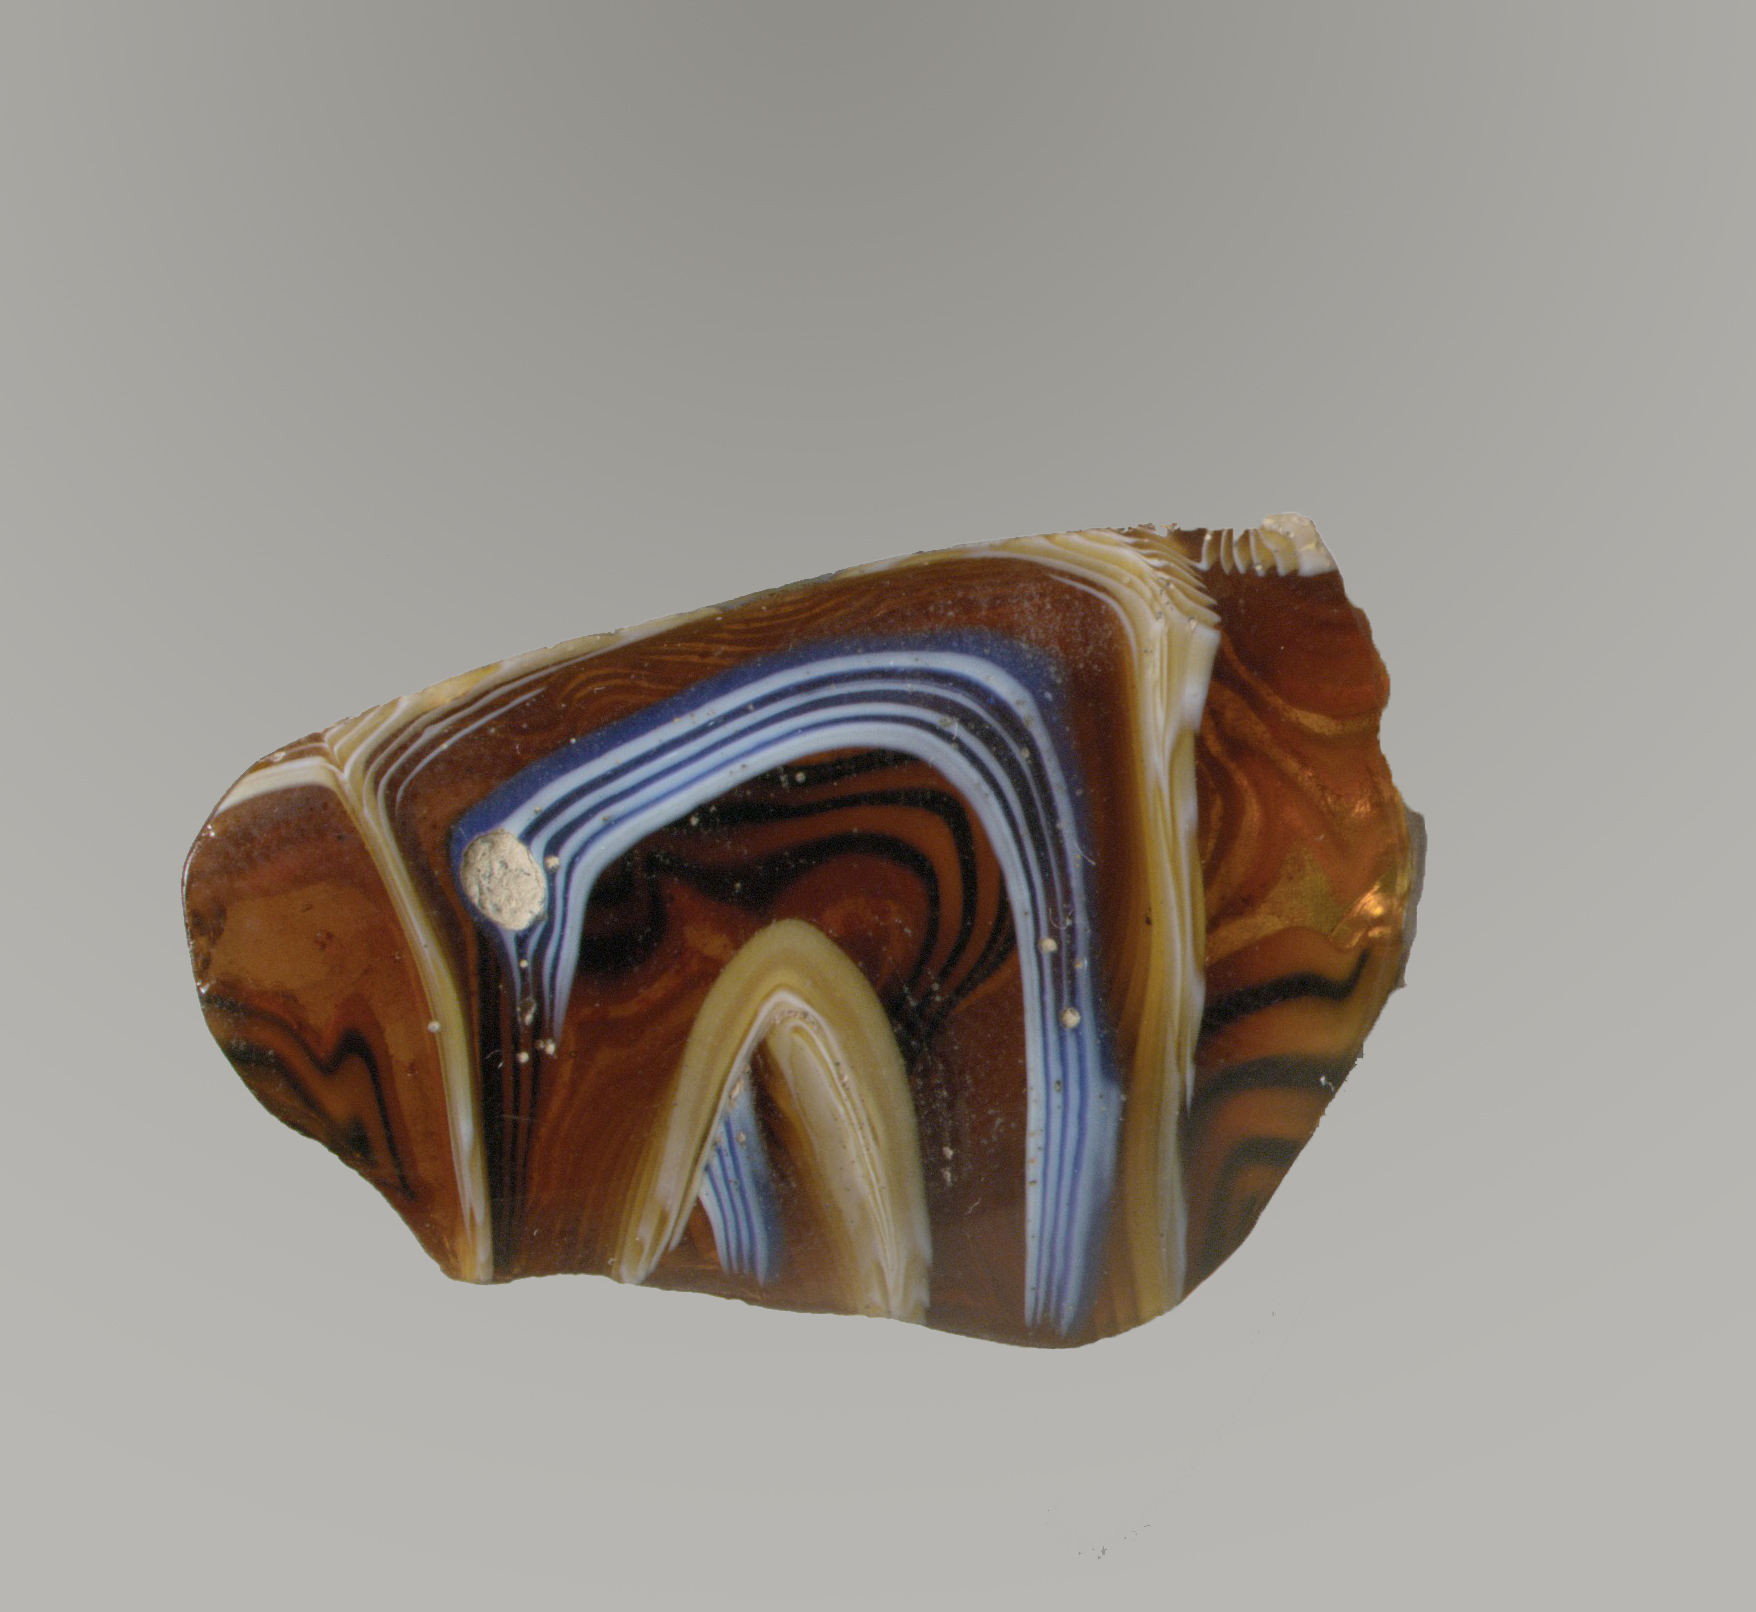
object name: fragment, mosaic bowl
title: Glass mosaic ribbed bowl fragment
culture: roman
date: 34 BCE-33 CE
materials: glass